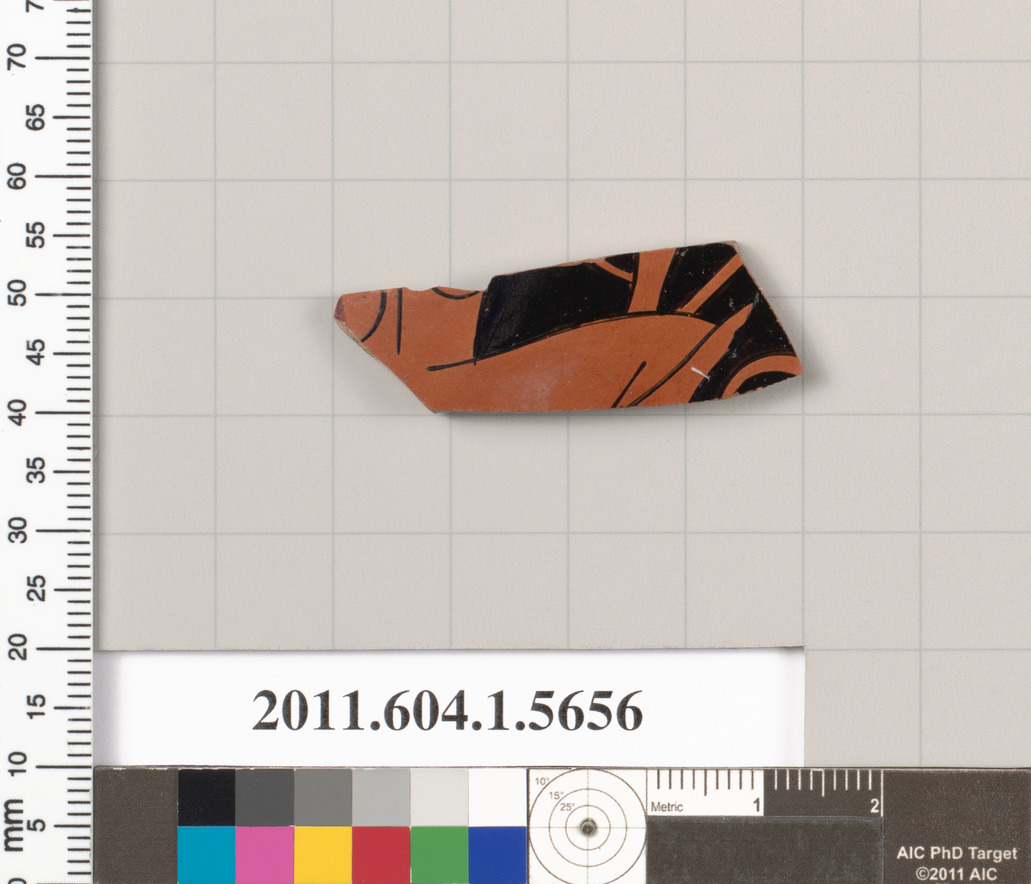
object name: kylix fragment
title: Terracotta fragment of a kylix (drinking cup)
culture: greek, attic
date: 520-500 BCE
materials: terracotta